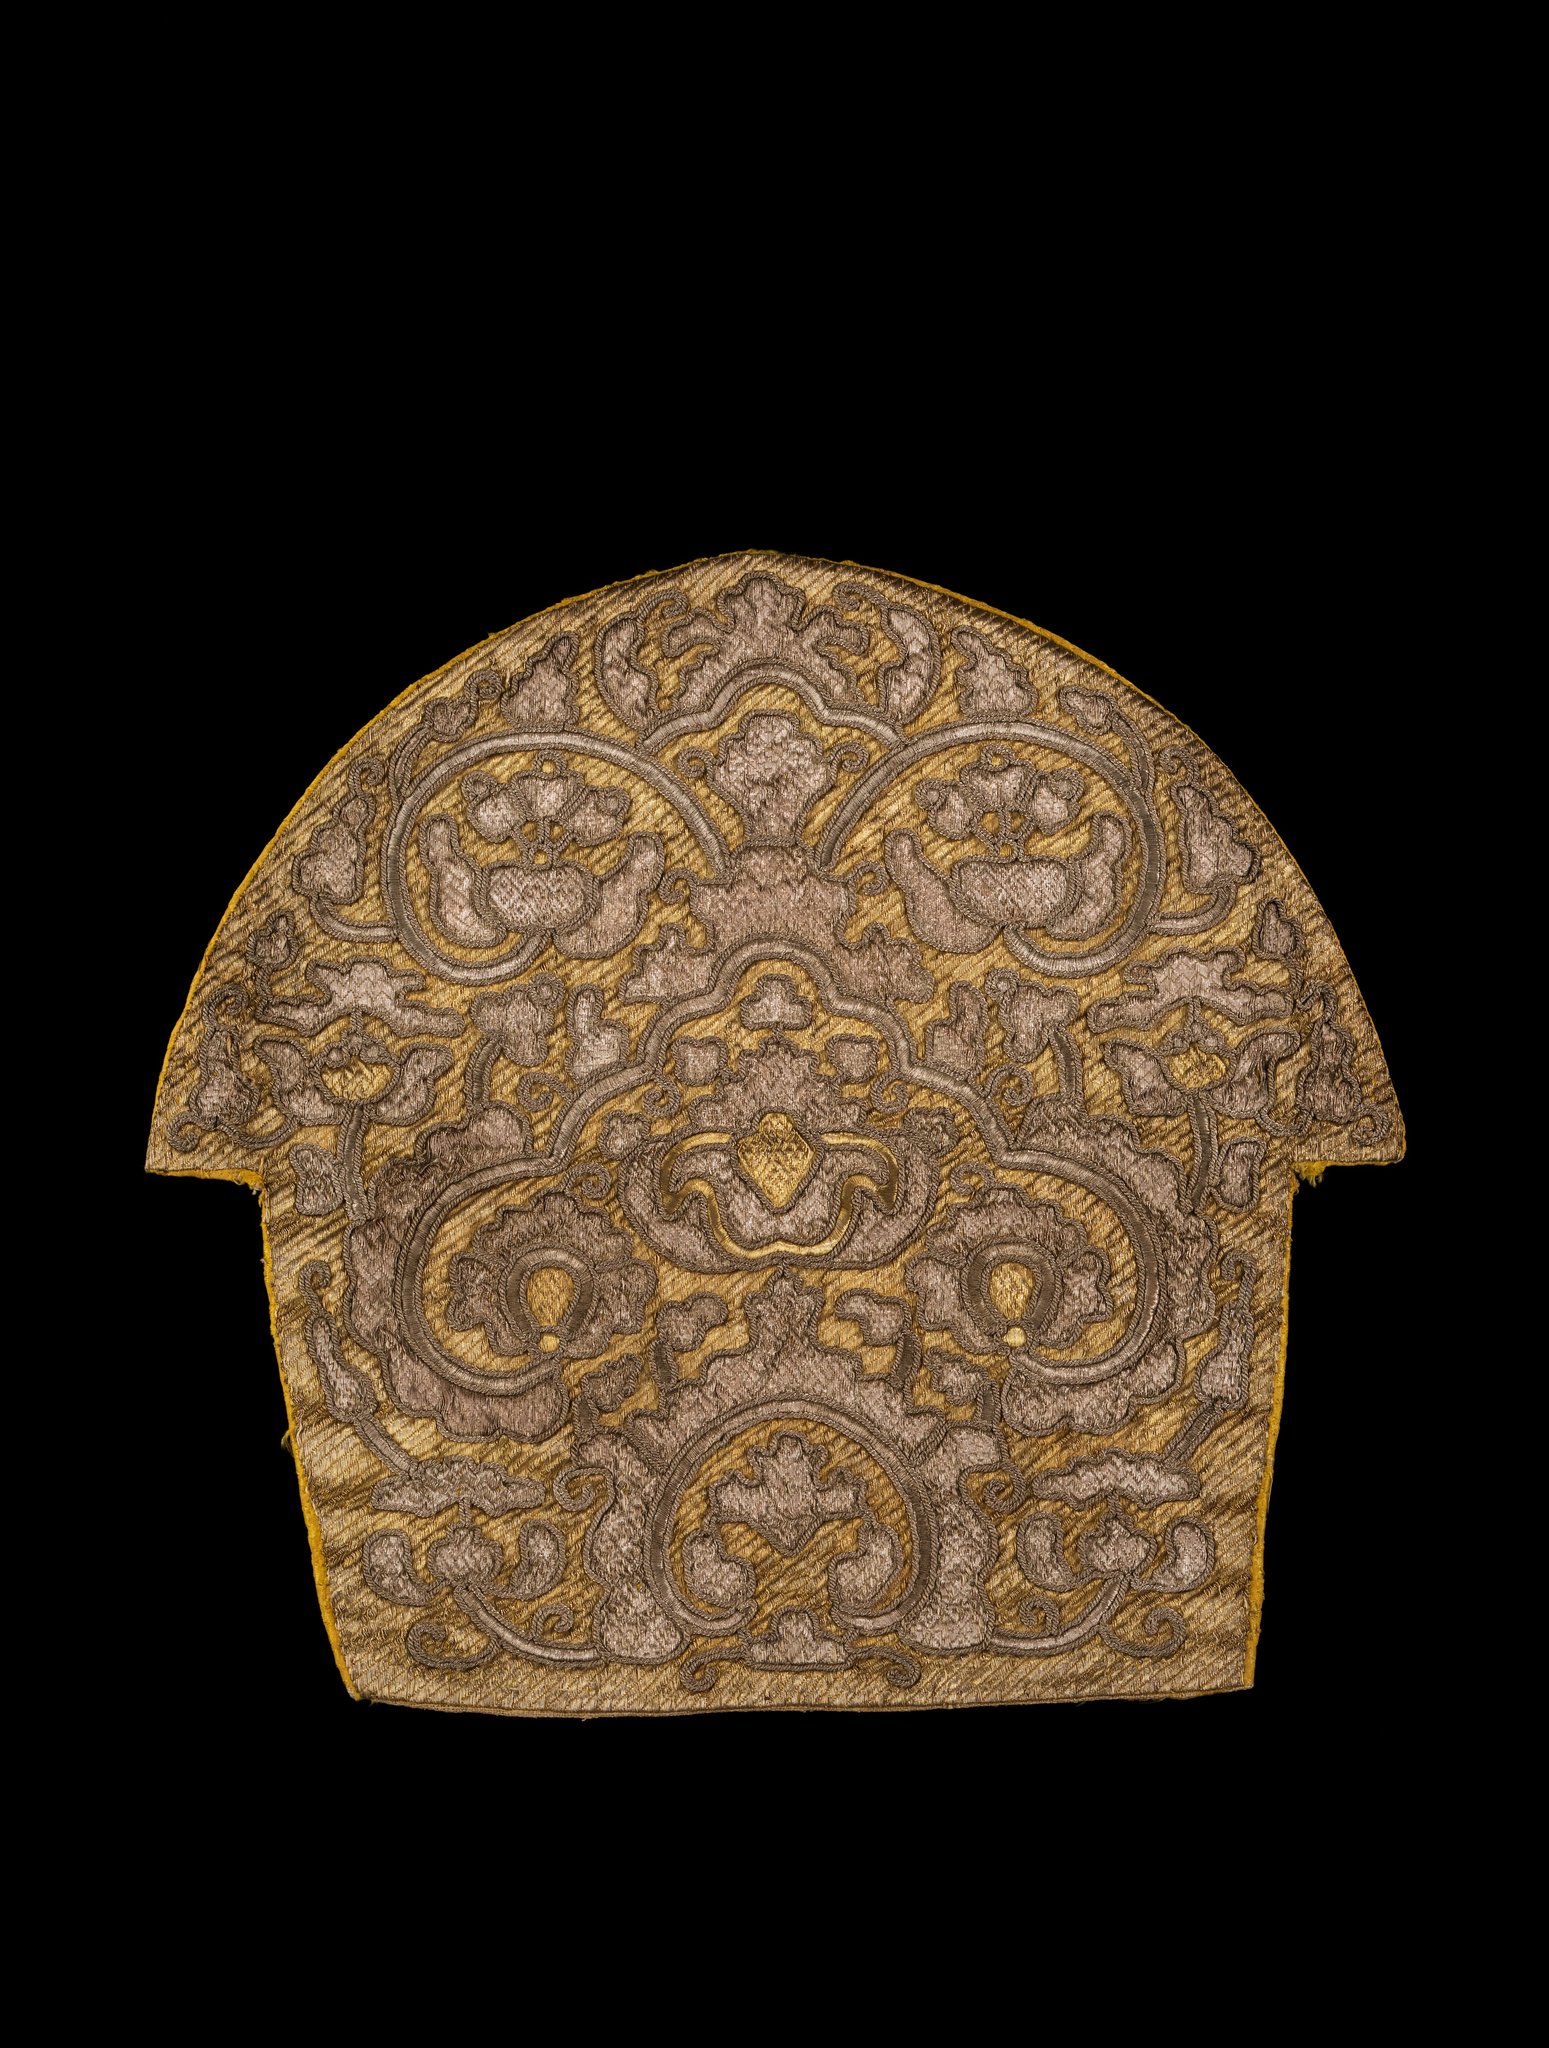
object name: headdress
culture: russian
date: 1801-1900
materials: linen, metal, silk